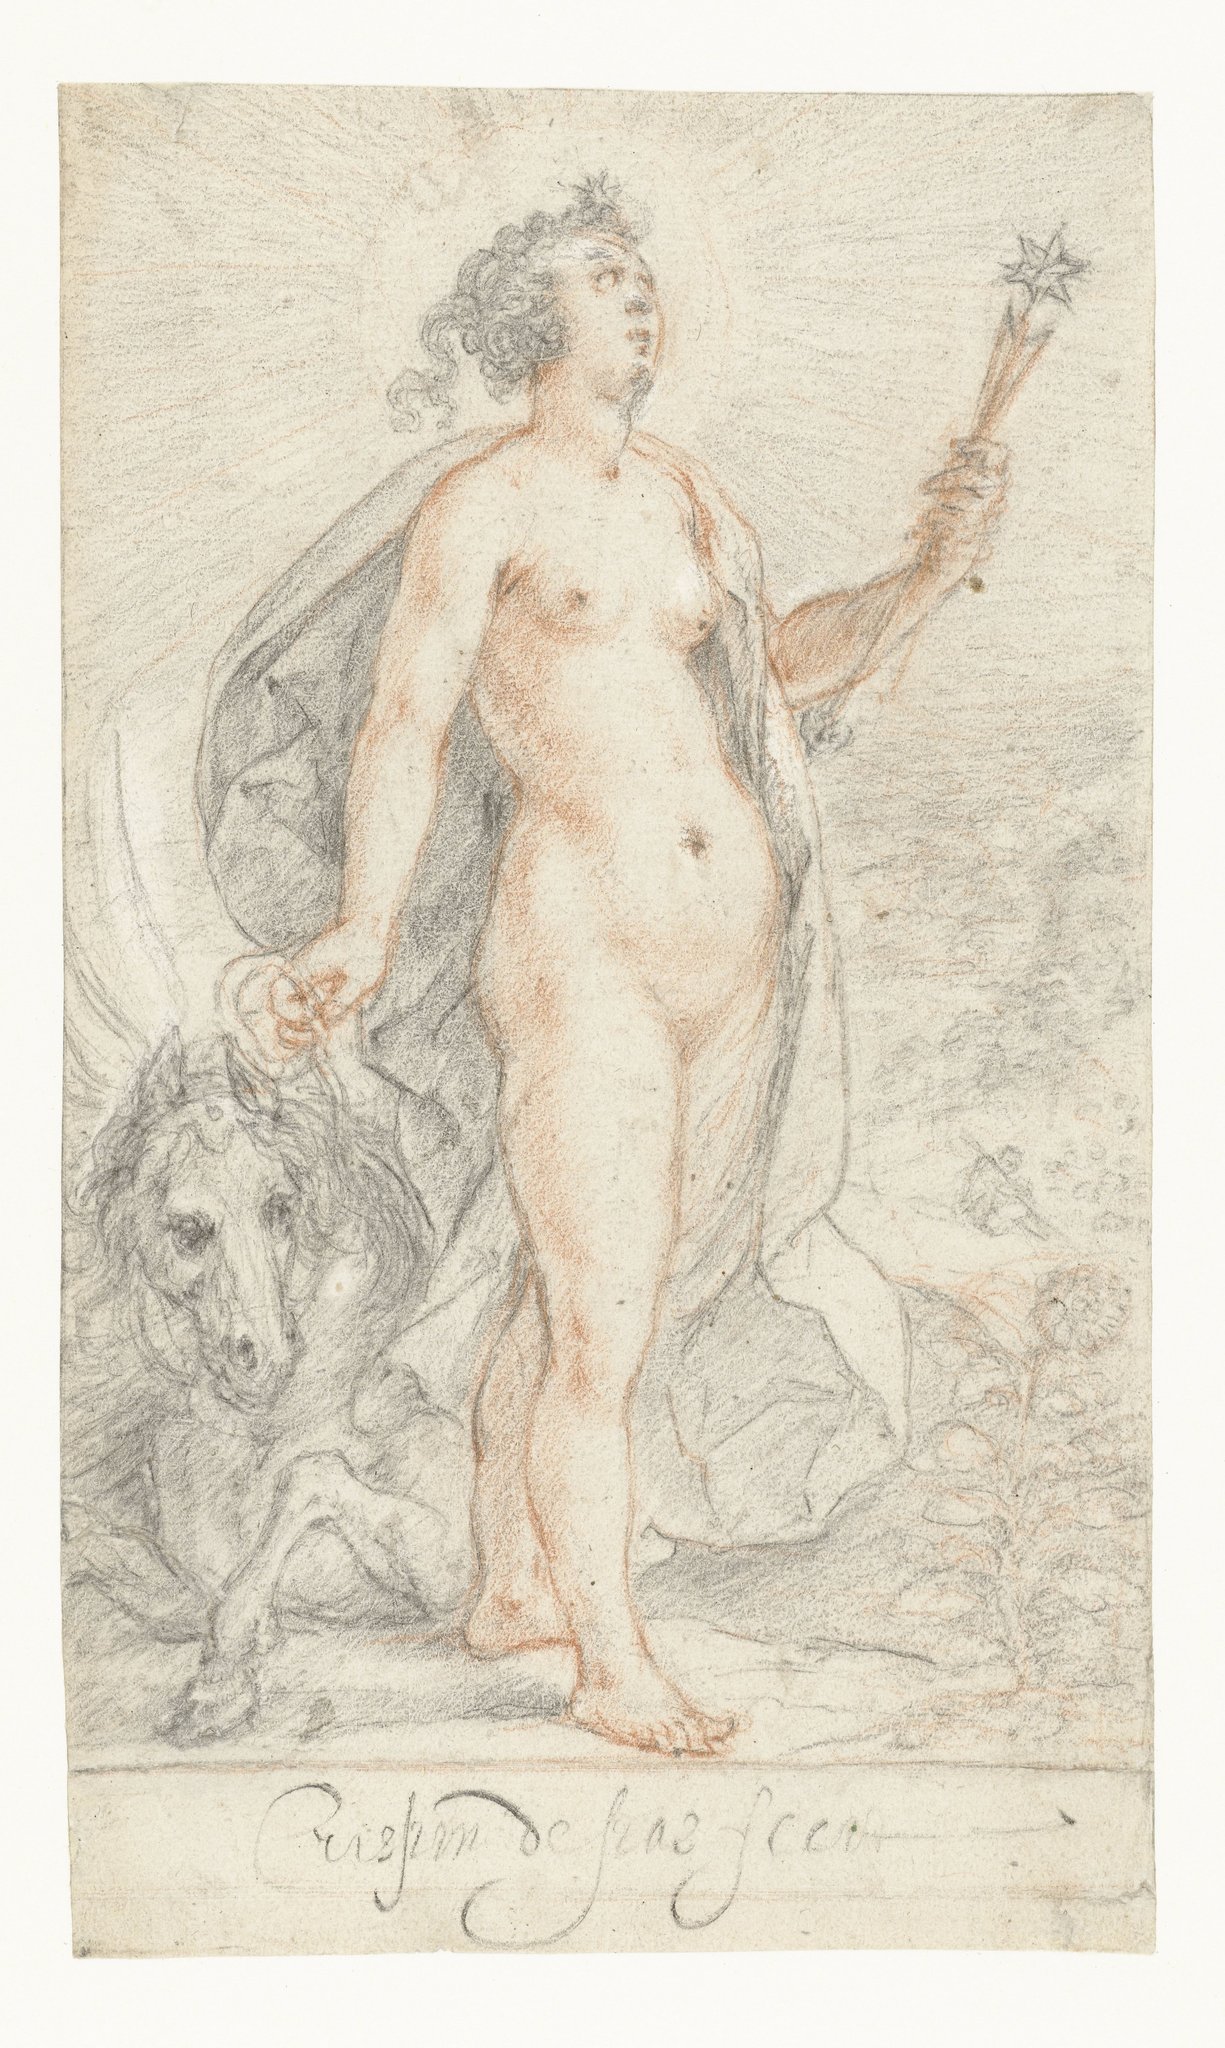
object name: design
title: De vier delen van de dag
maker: crispijn van de passe (i)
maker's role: draughtsman, print maker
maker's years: 1564-1637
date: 1575-1635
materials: chalk, paper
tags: morning